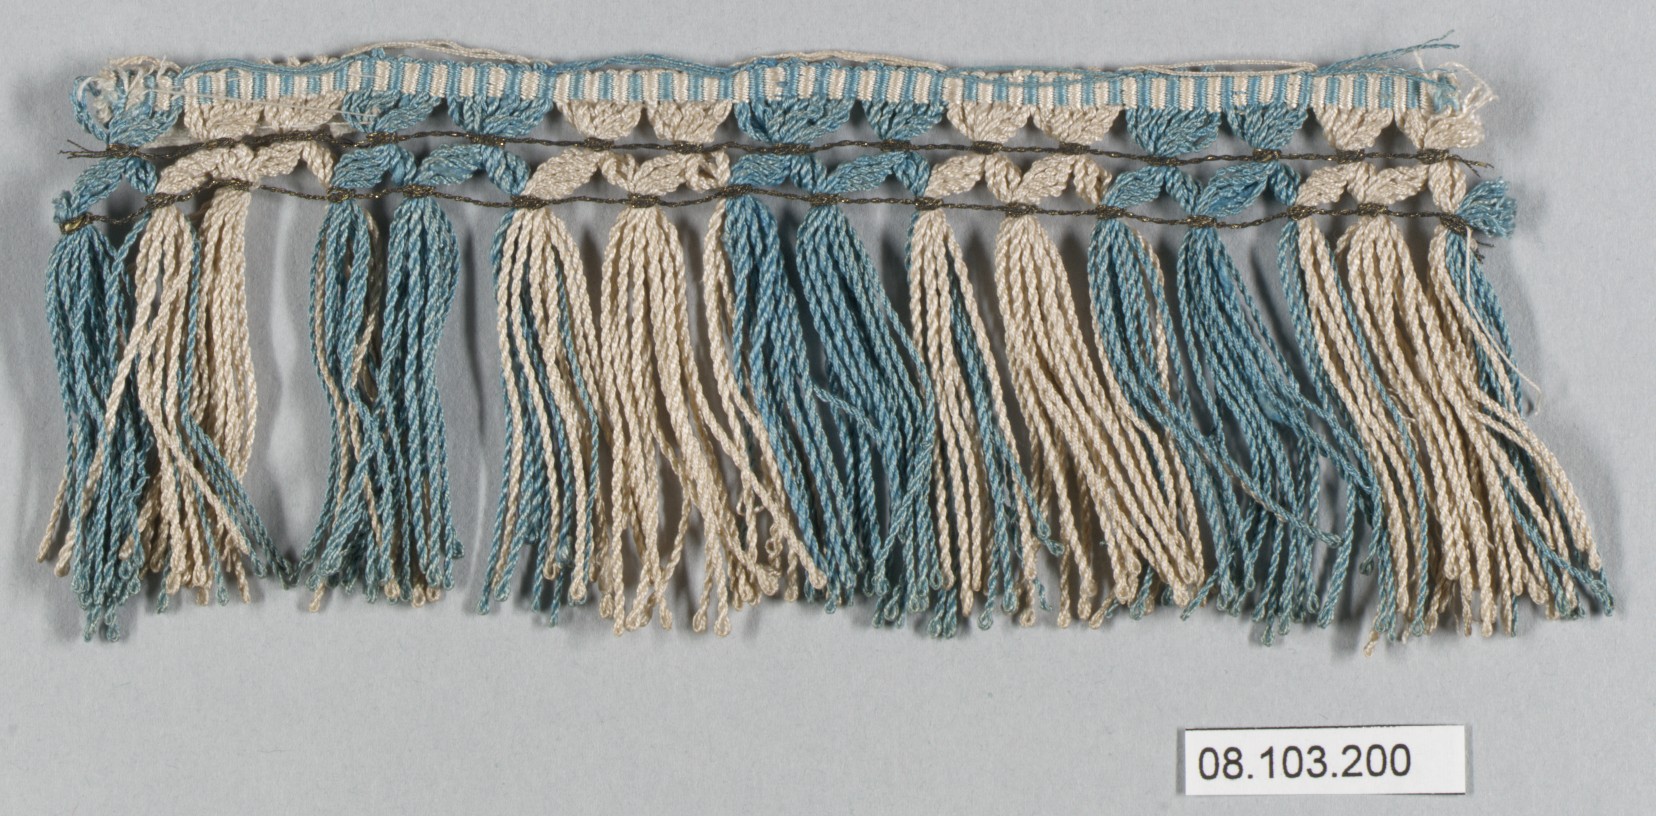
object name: fringe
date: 1801-1900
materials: silk